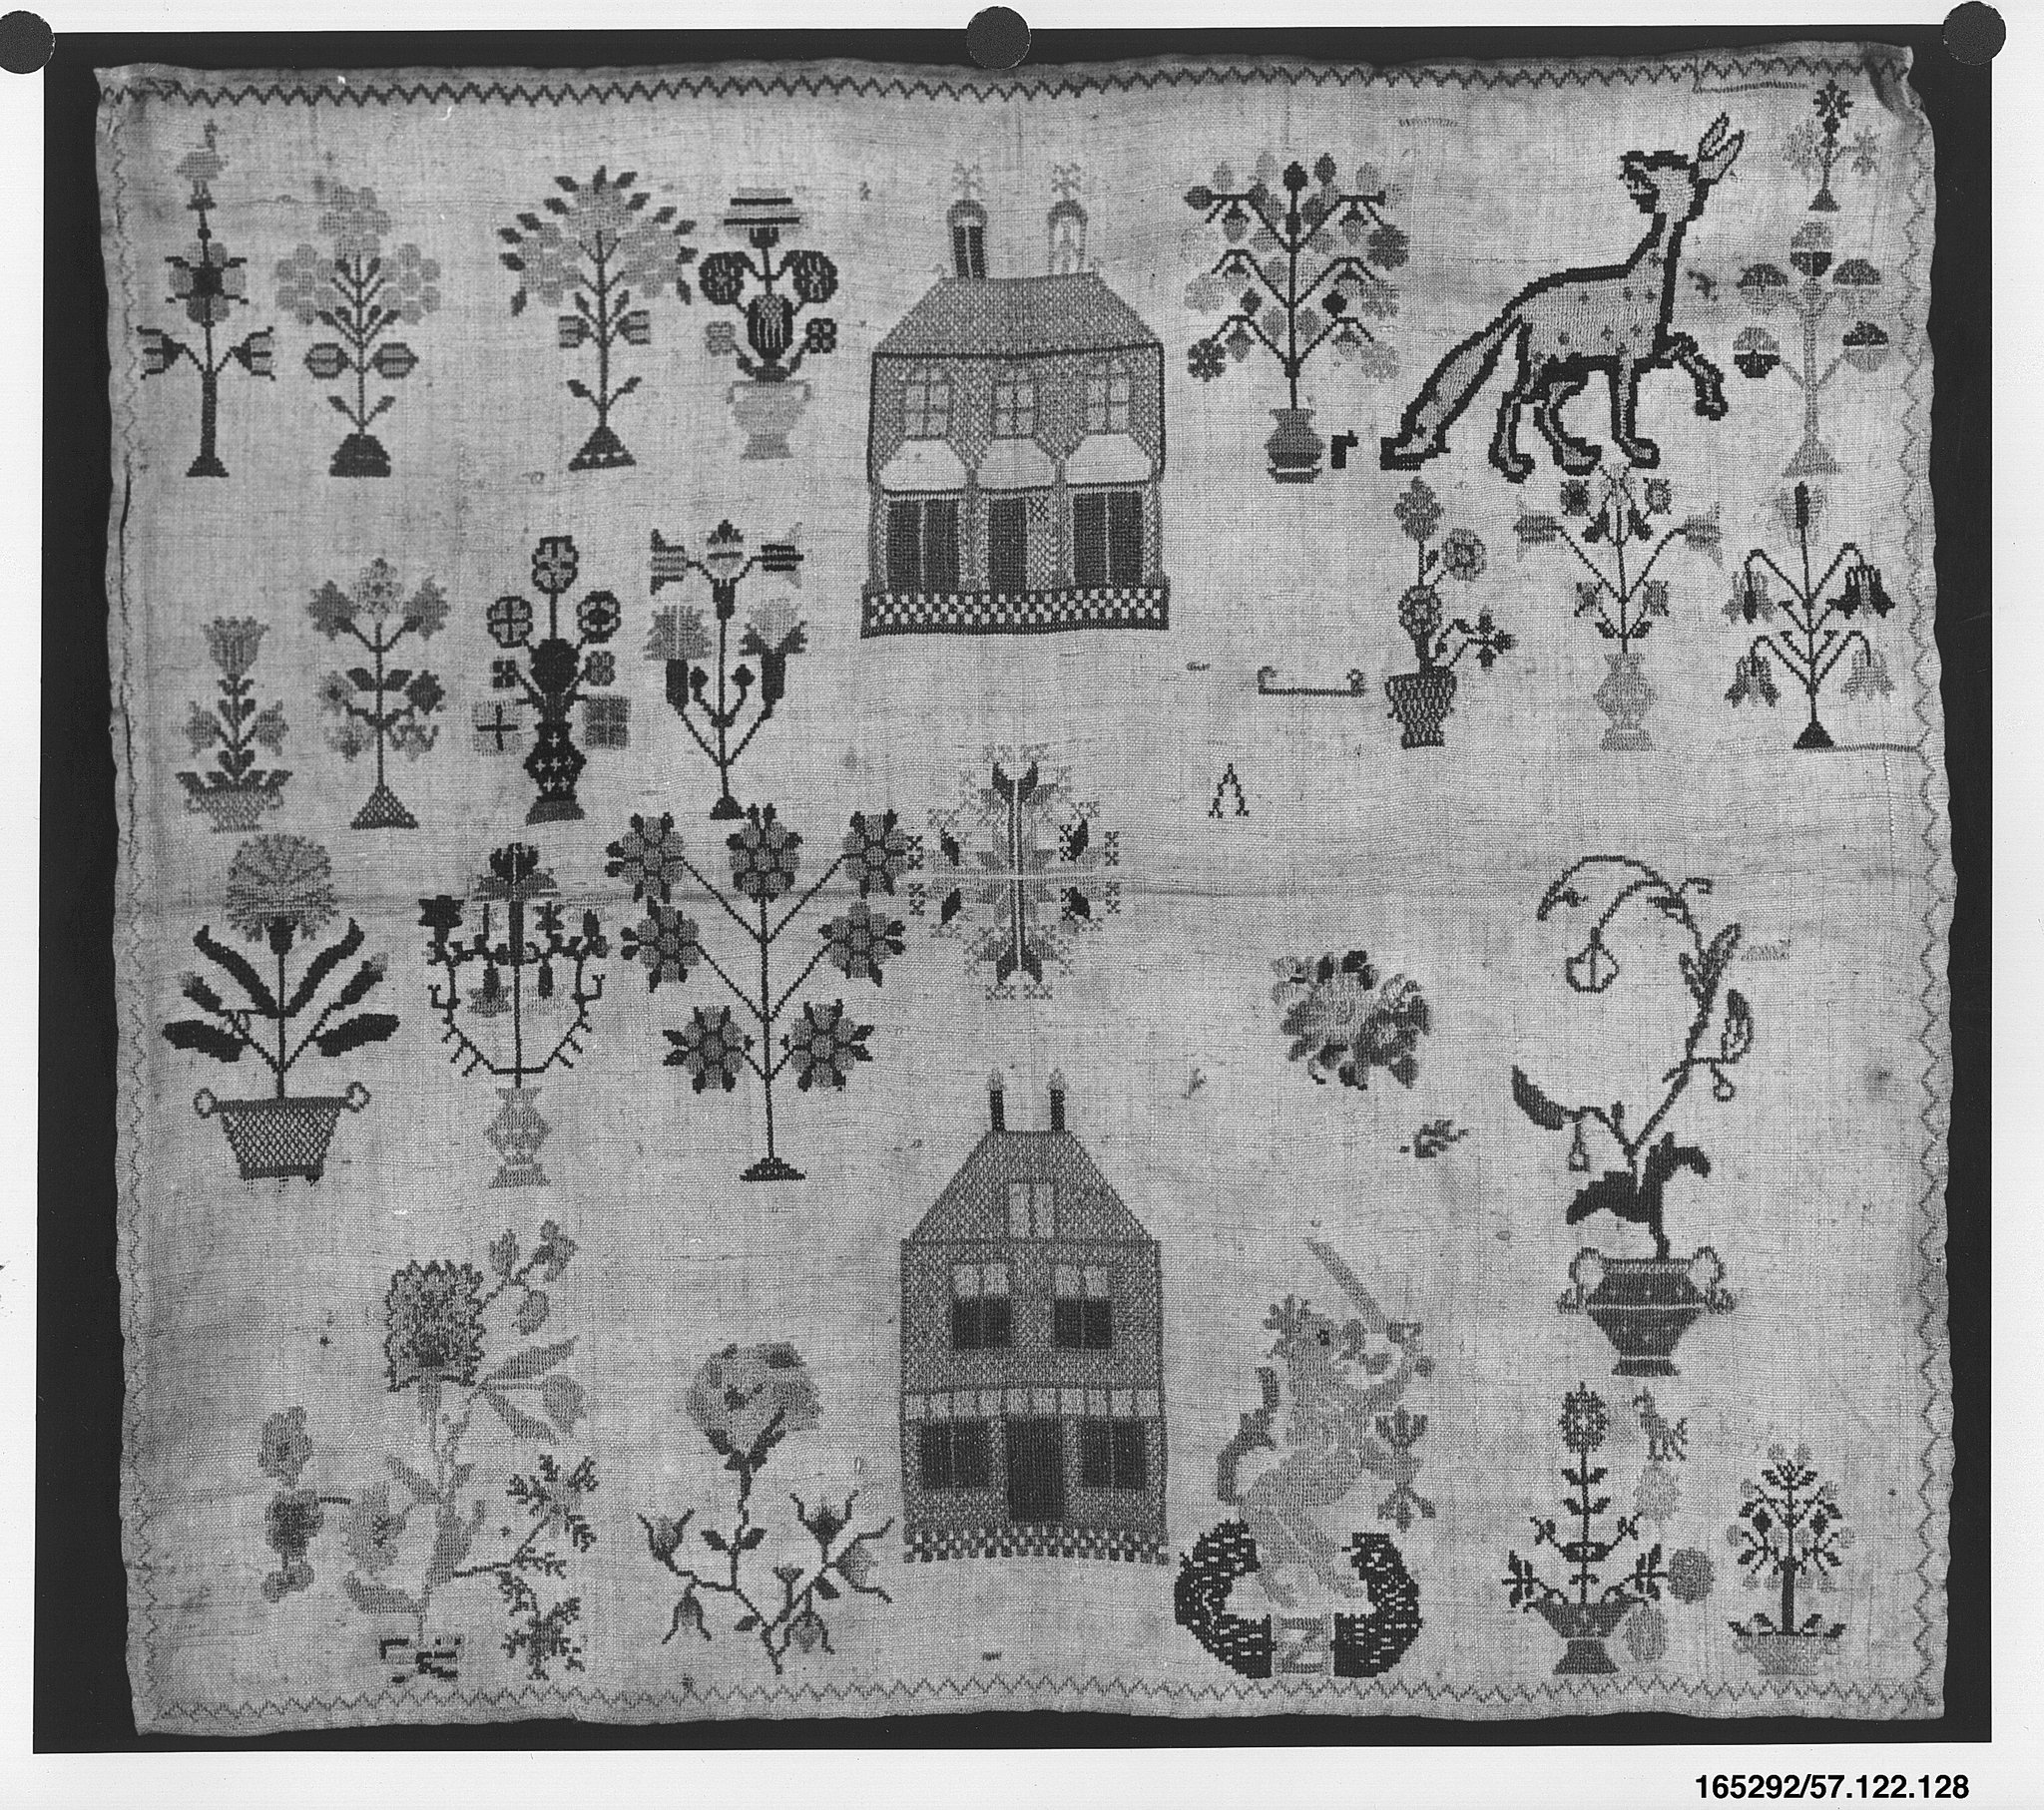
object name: sampler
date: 1780-1800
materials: cotton, linen, silk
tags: animals,houses,flowers,insignia